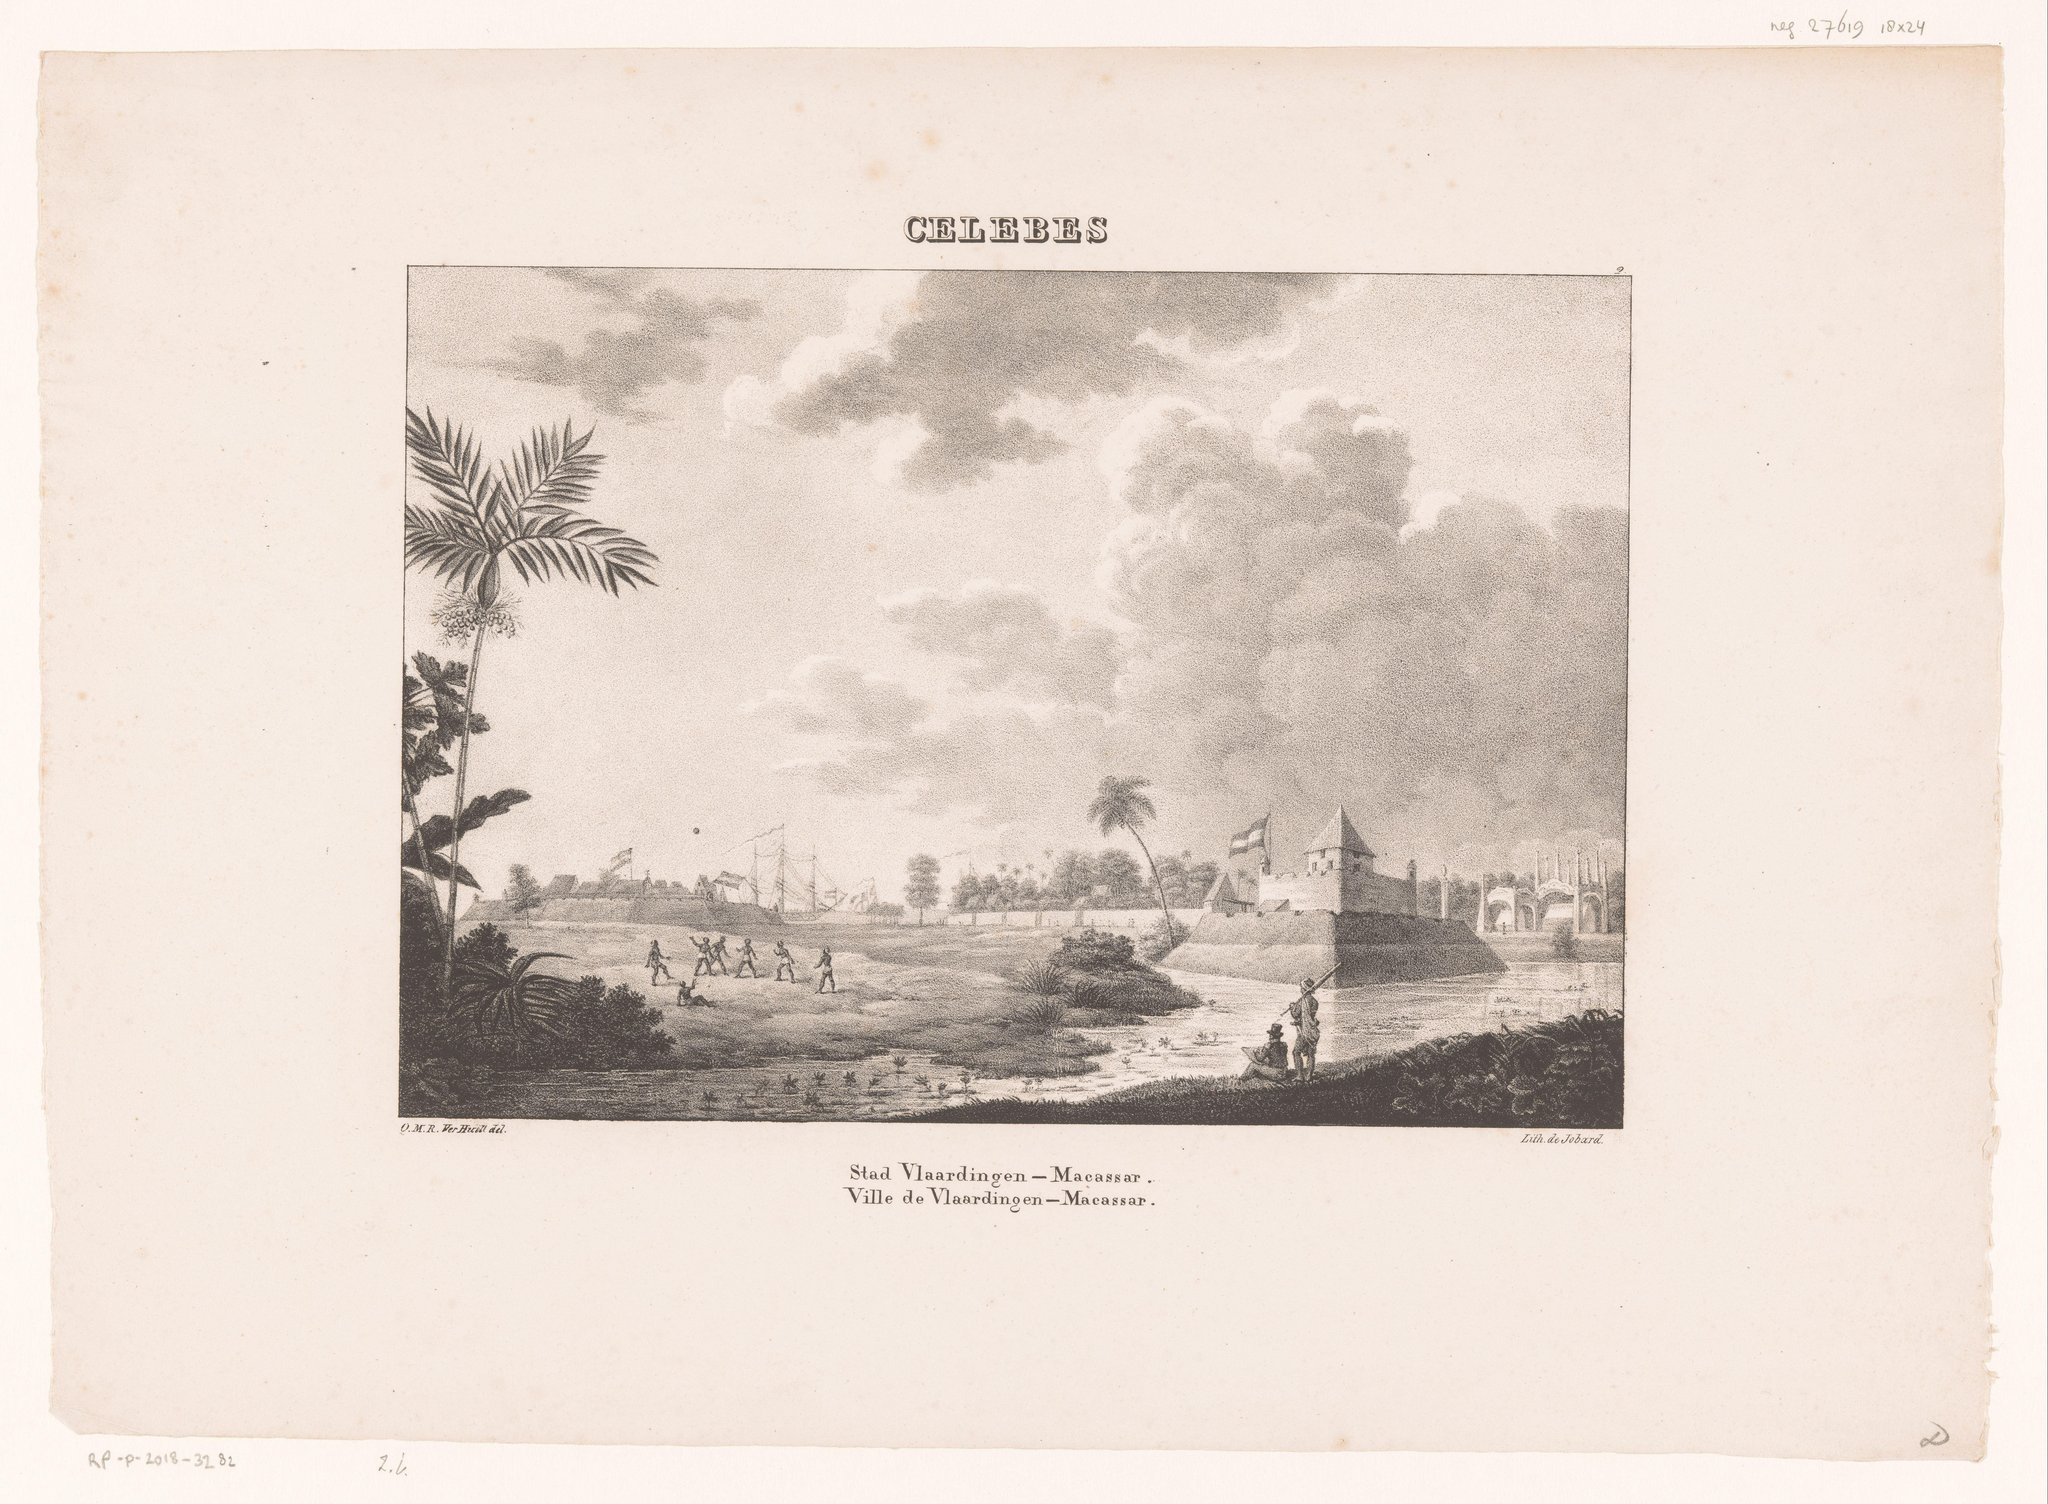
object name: print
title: Stad Vlaardingen-Macassar / Ville de Vlaardingen-Macassar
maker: jean baptiste ambroise marcellin jobard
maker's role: print maker, publisher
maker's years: 1792-1861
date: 1824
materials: paper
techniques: lithograph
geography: rotterdam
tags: village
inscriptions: collector's mark: Lugt 2228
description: Prent uit: Ver Huell, Quirijn Maurits Rudolf. Gezigten in Oost-Indië, naar de natuur getekend, met een beschrijving. Rotterdam: Arbon en Krap, 1824.